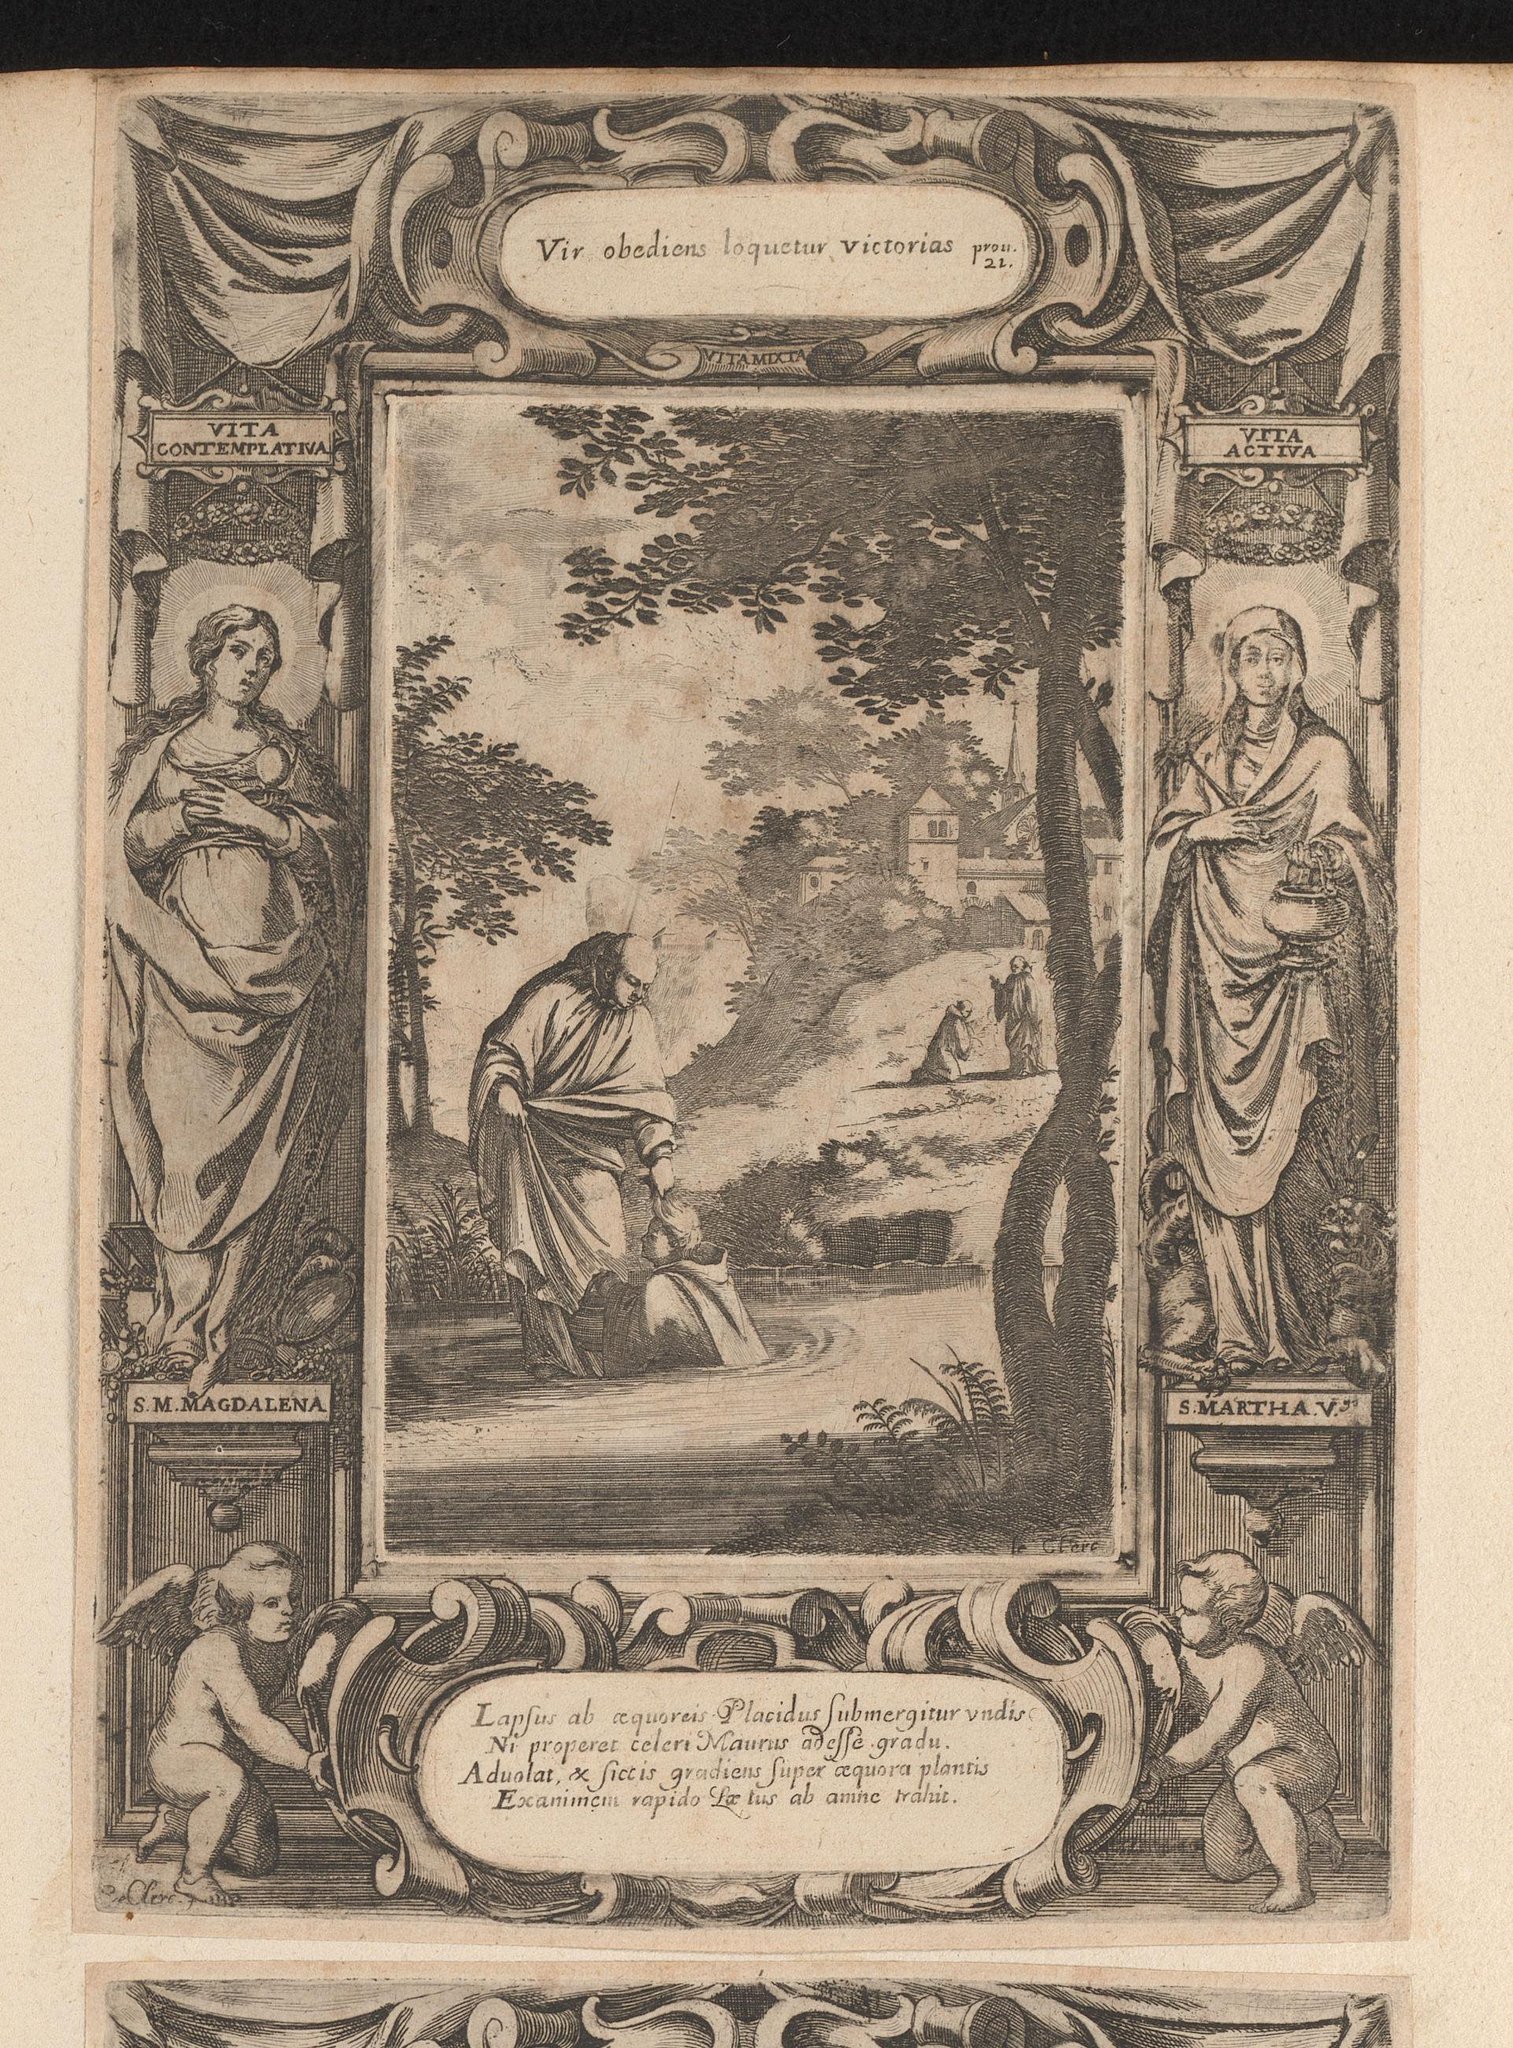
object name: album leaf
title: Vita et Miracula Sanctissimi Patris Benedecti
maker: sébastien leclerc (i)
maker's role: print maker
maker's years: 1637-1714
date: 1658-1659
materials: paper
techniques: etching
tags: the rescue of st. placidus, who had fallen into a lake: st. benedict, learning of the accident in a vision, sends st. maurus, who walks on the water and pulls st. placidus out by the hair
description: Maakt deel uit van een serie bestaande uit 33 prenten met voorstellingen uit het leven van de Heilige Benedictus van Nursia in ornamentele cartouches, uitgegeven in 1658-1659. De prenten zijn gedrukt van drie afzonderlijke platen bestaande uit de voorstelling, de cartouche en de tekst.